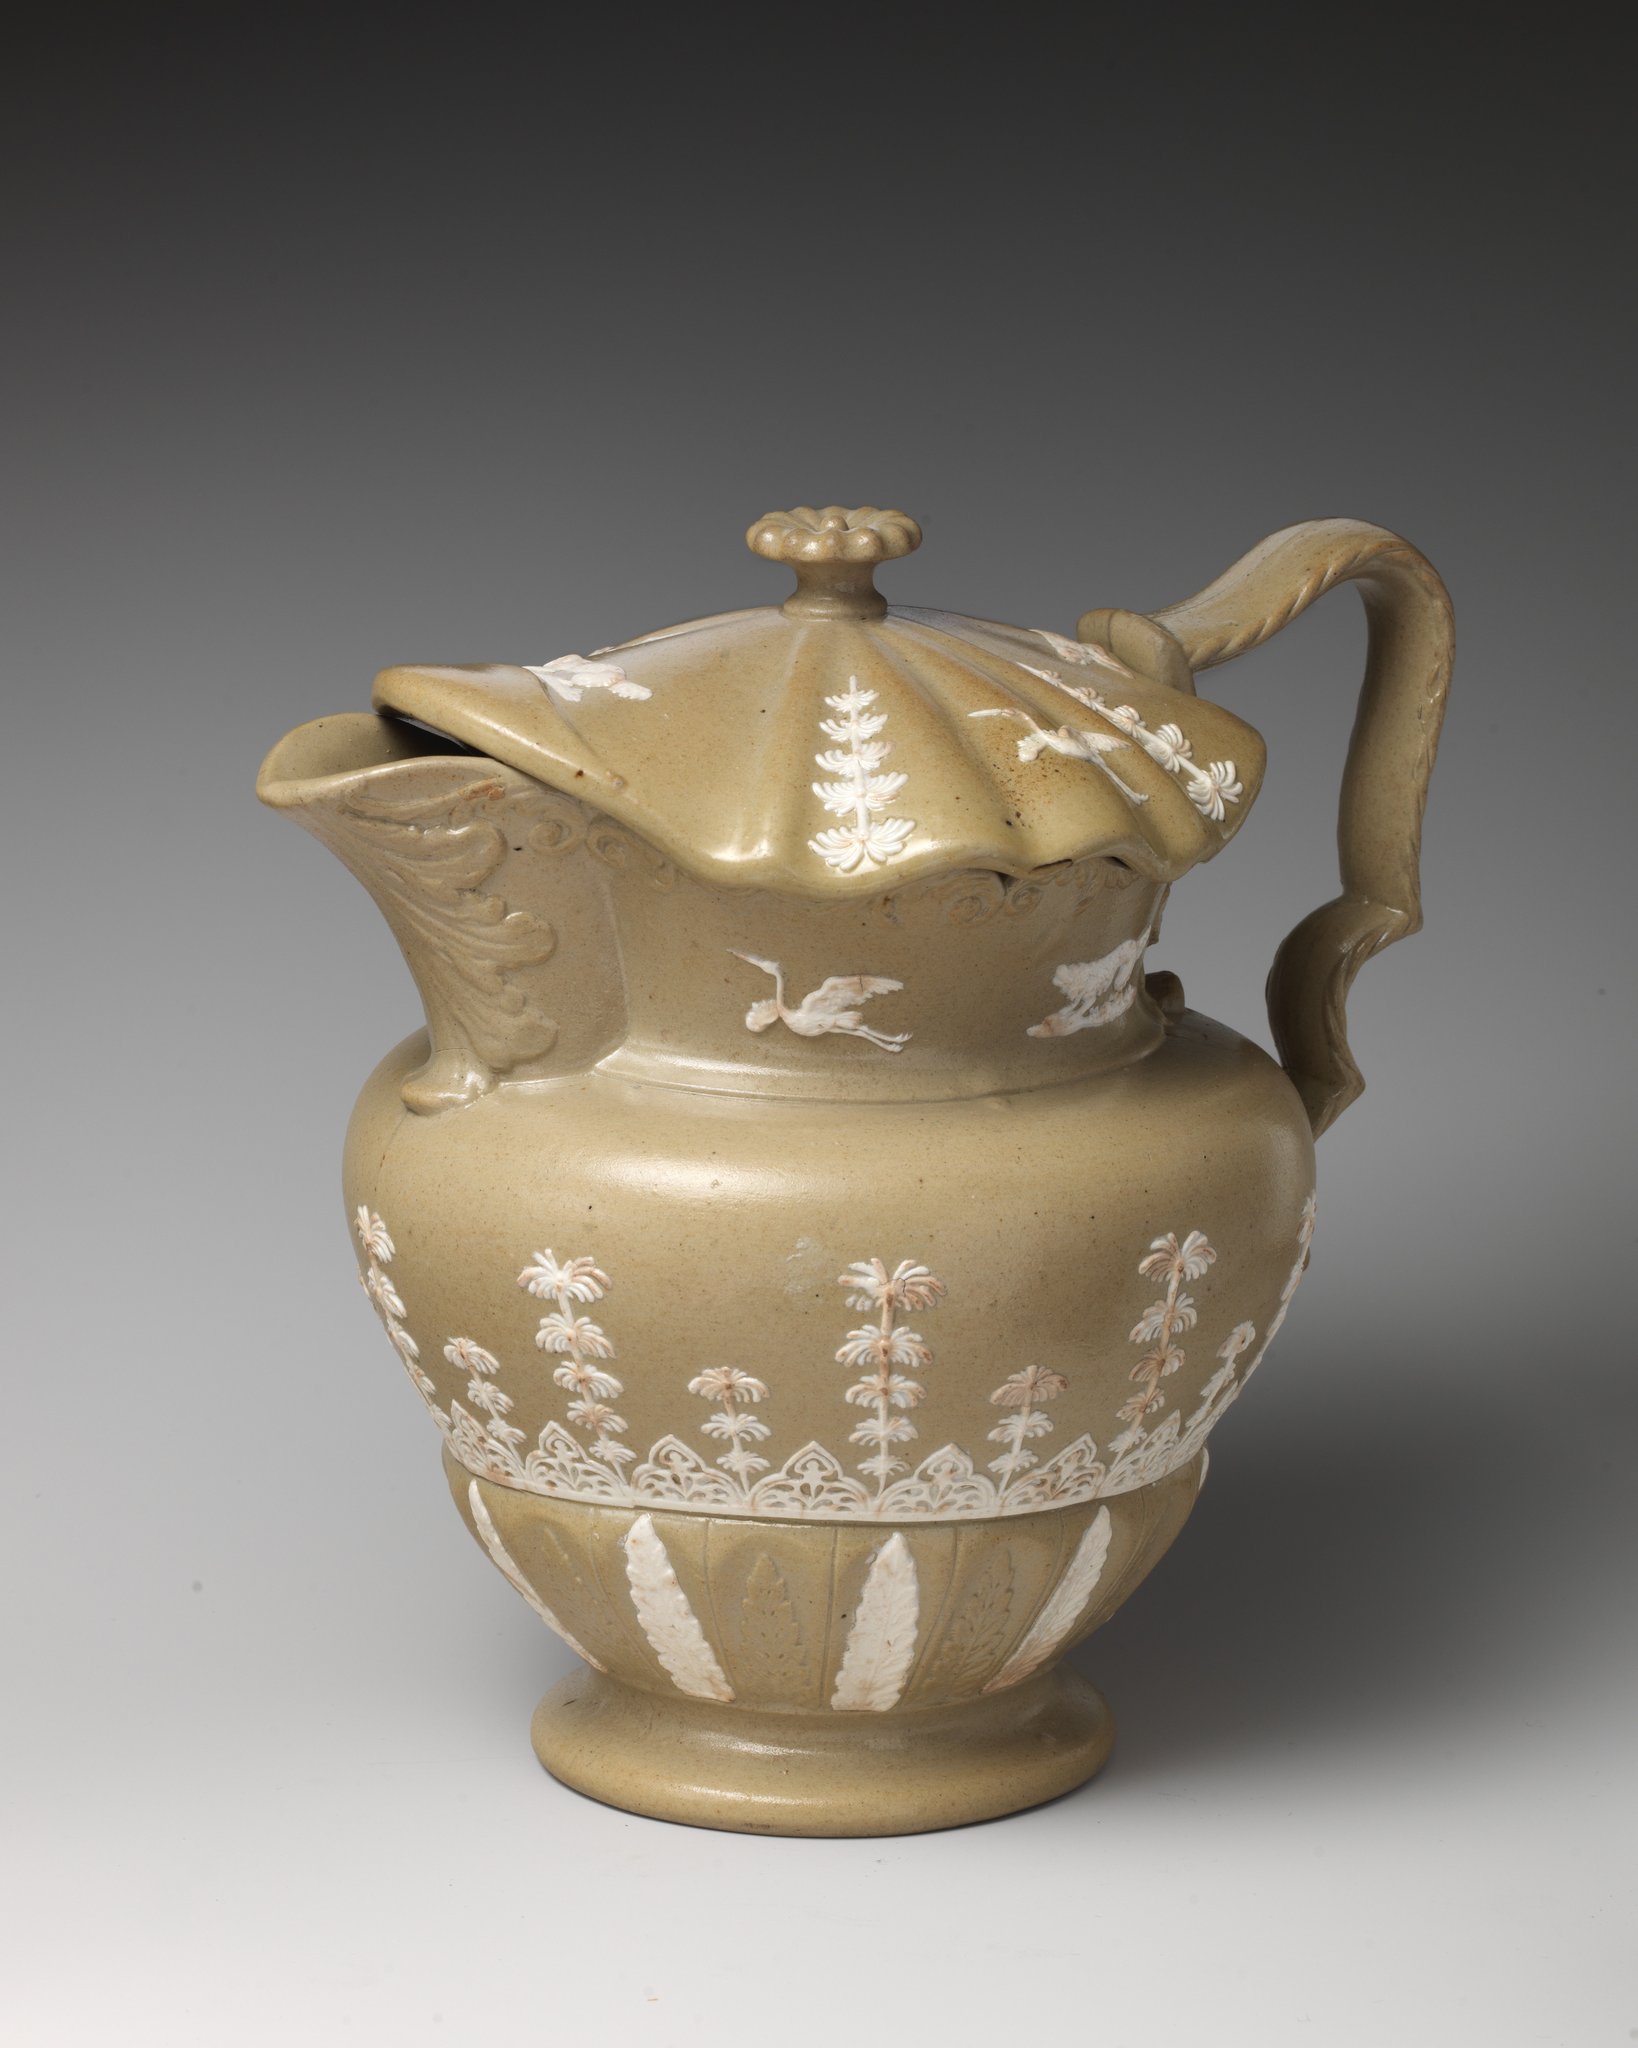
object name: cider jug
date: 1801-1900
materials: stone